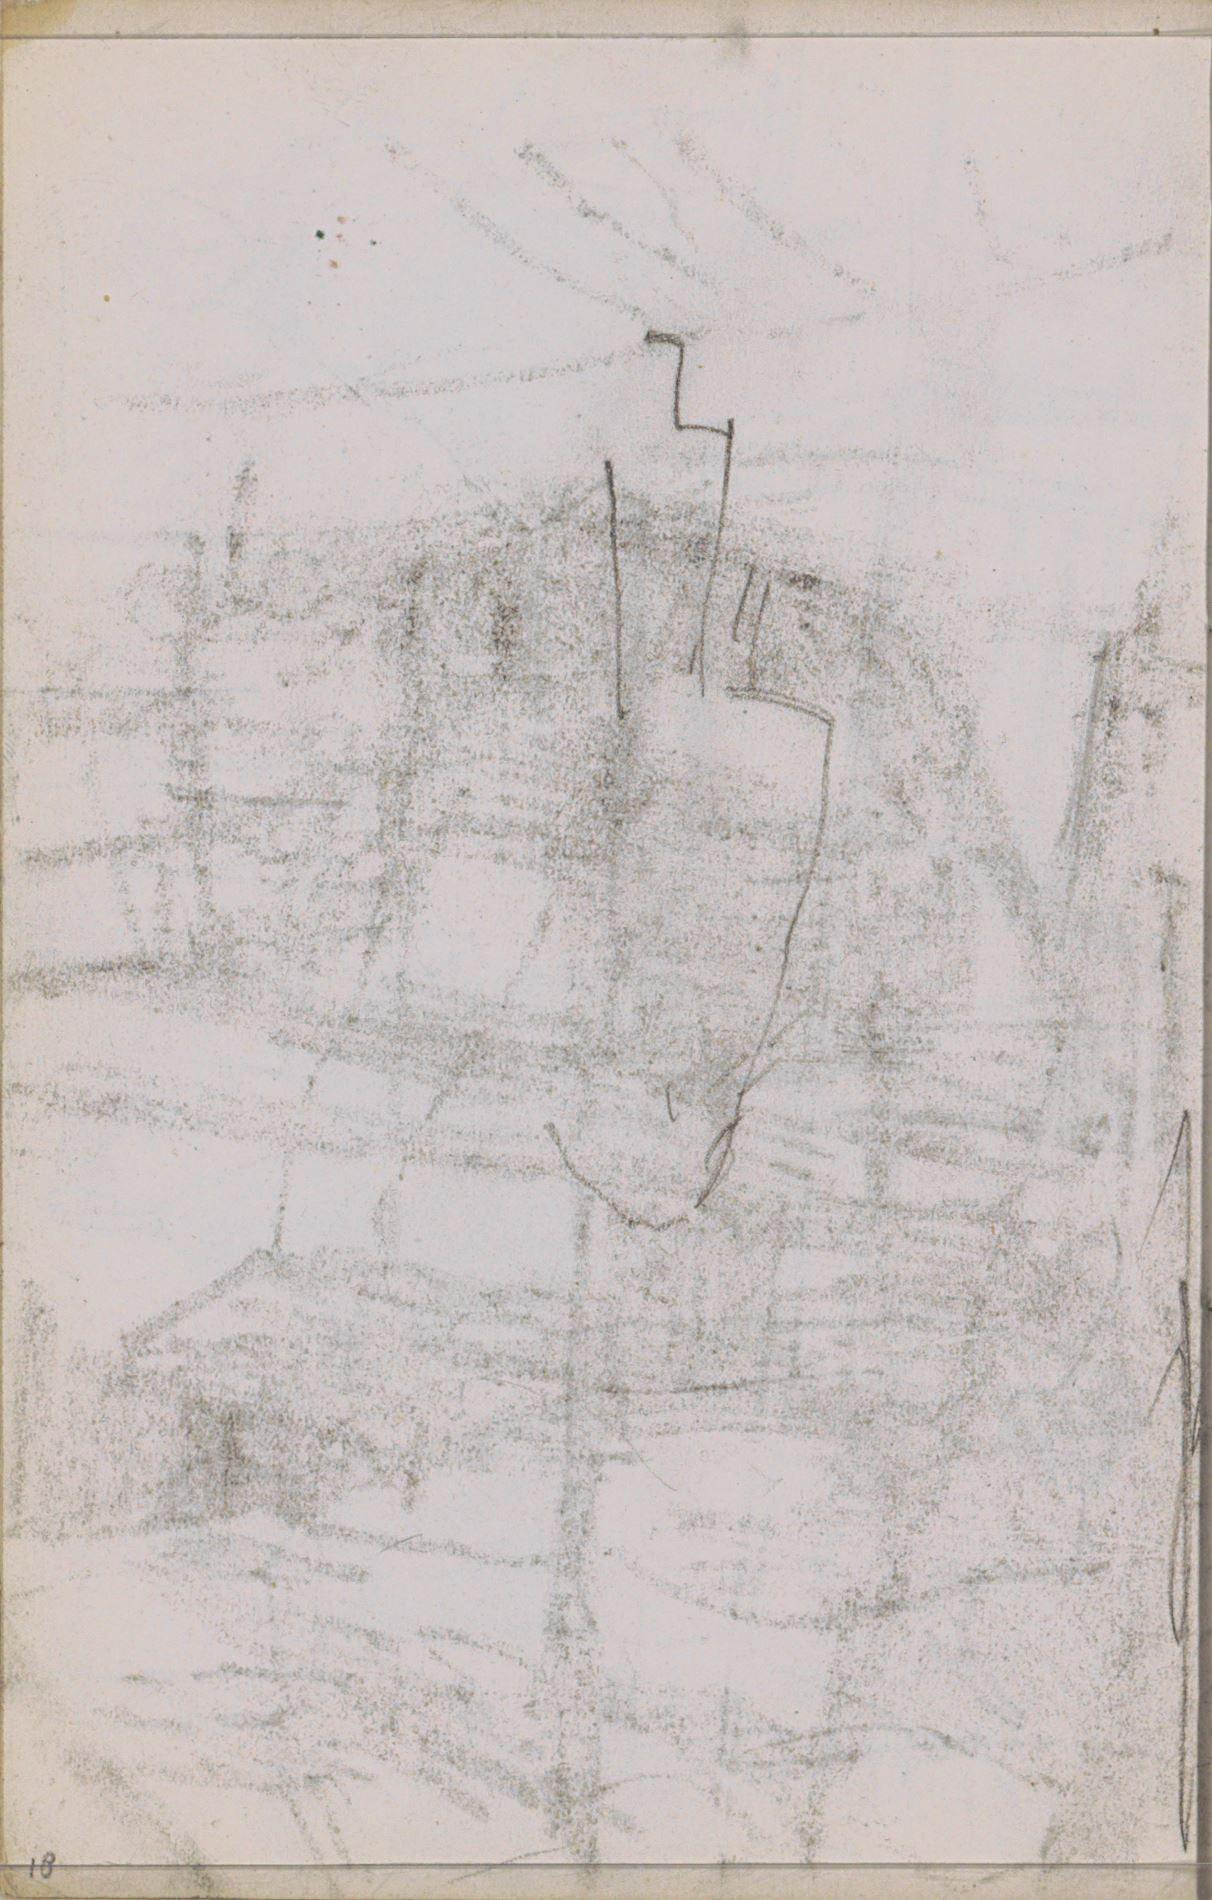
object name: sketchbook leaf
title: Studie, mogelijk een figuurstudie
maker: isaac israels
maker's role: draughtsman, painter, print maker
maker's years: 1865-1934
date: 1875-1934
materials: chalk, paper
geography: amsterdam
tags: the (nude) human figure; 'corpo humano' (ripa) - aa - female human figure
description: Pagina 18 uit schetsboek XXIX met 44 pagina's.